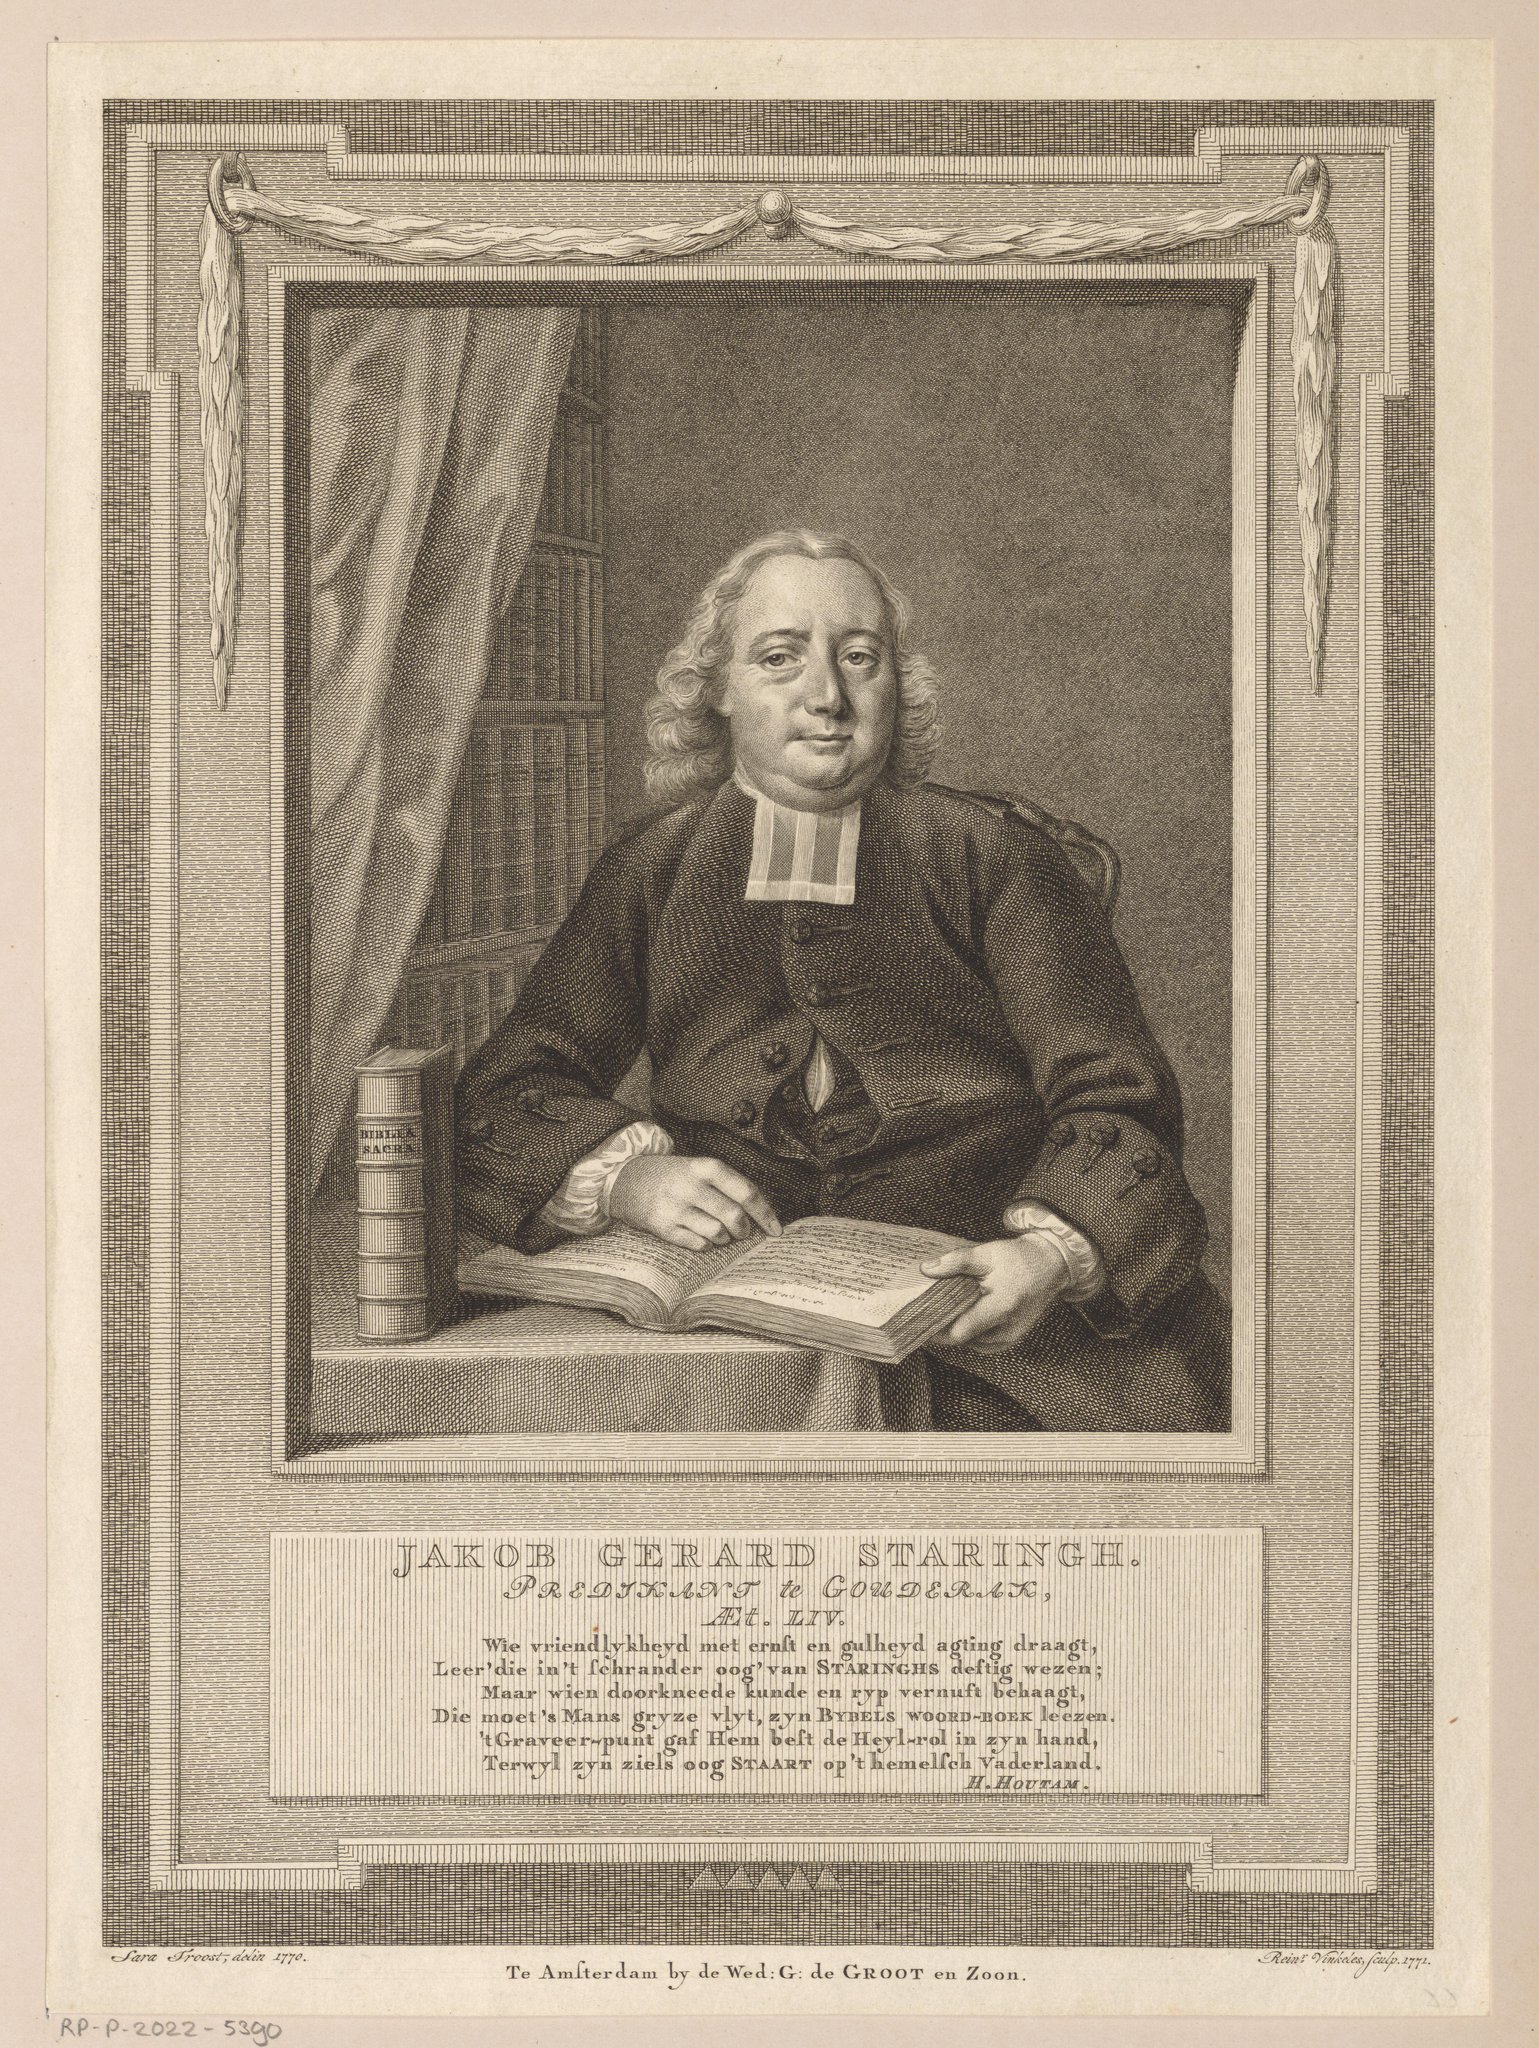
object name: print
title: Portret van Jacobus Gerardus Staring op 54-jarige leeftijd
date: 1771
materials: paper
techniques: engraving, etching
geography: amsterdam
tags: historical persons, functionaries and dignitaries (with name) ~ episcopal protestant churches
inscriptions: collector's mark: Lugt 240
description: Met achtregelig onderschrift in het Nederlands.